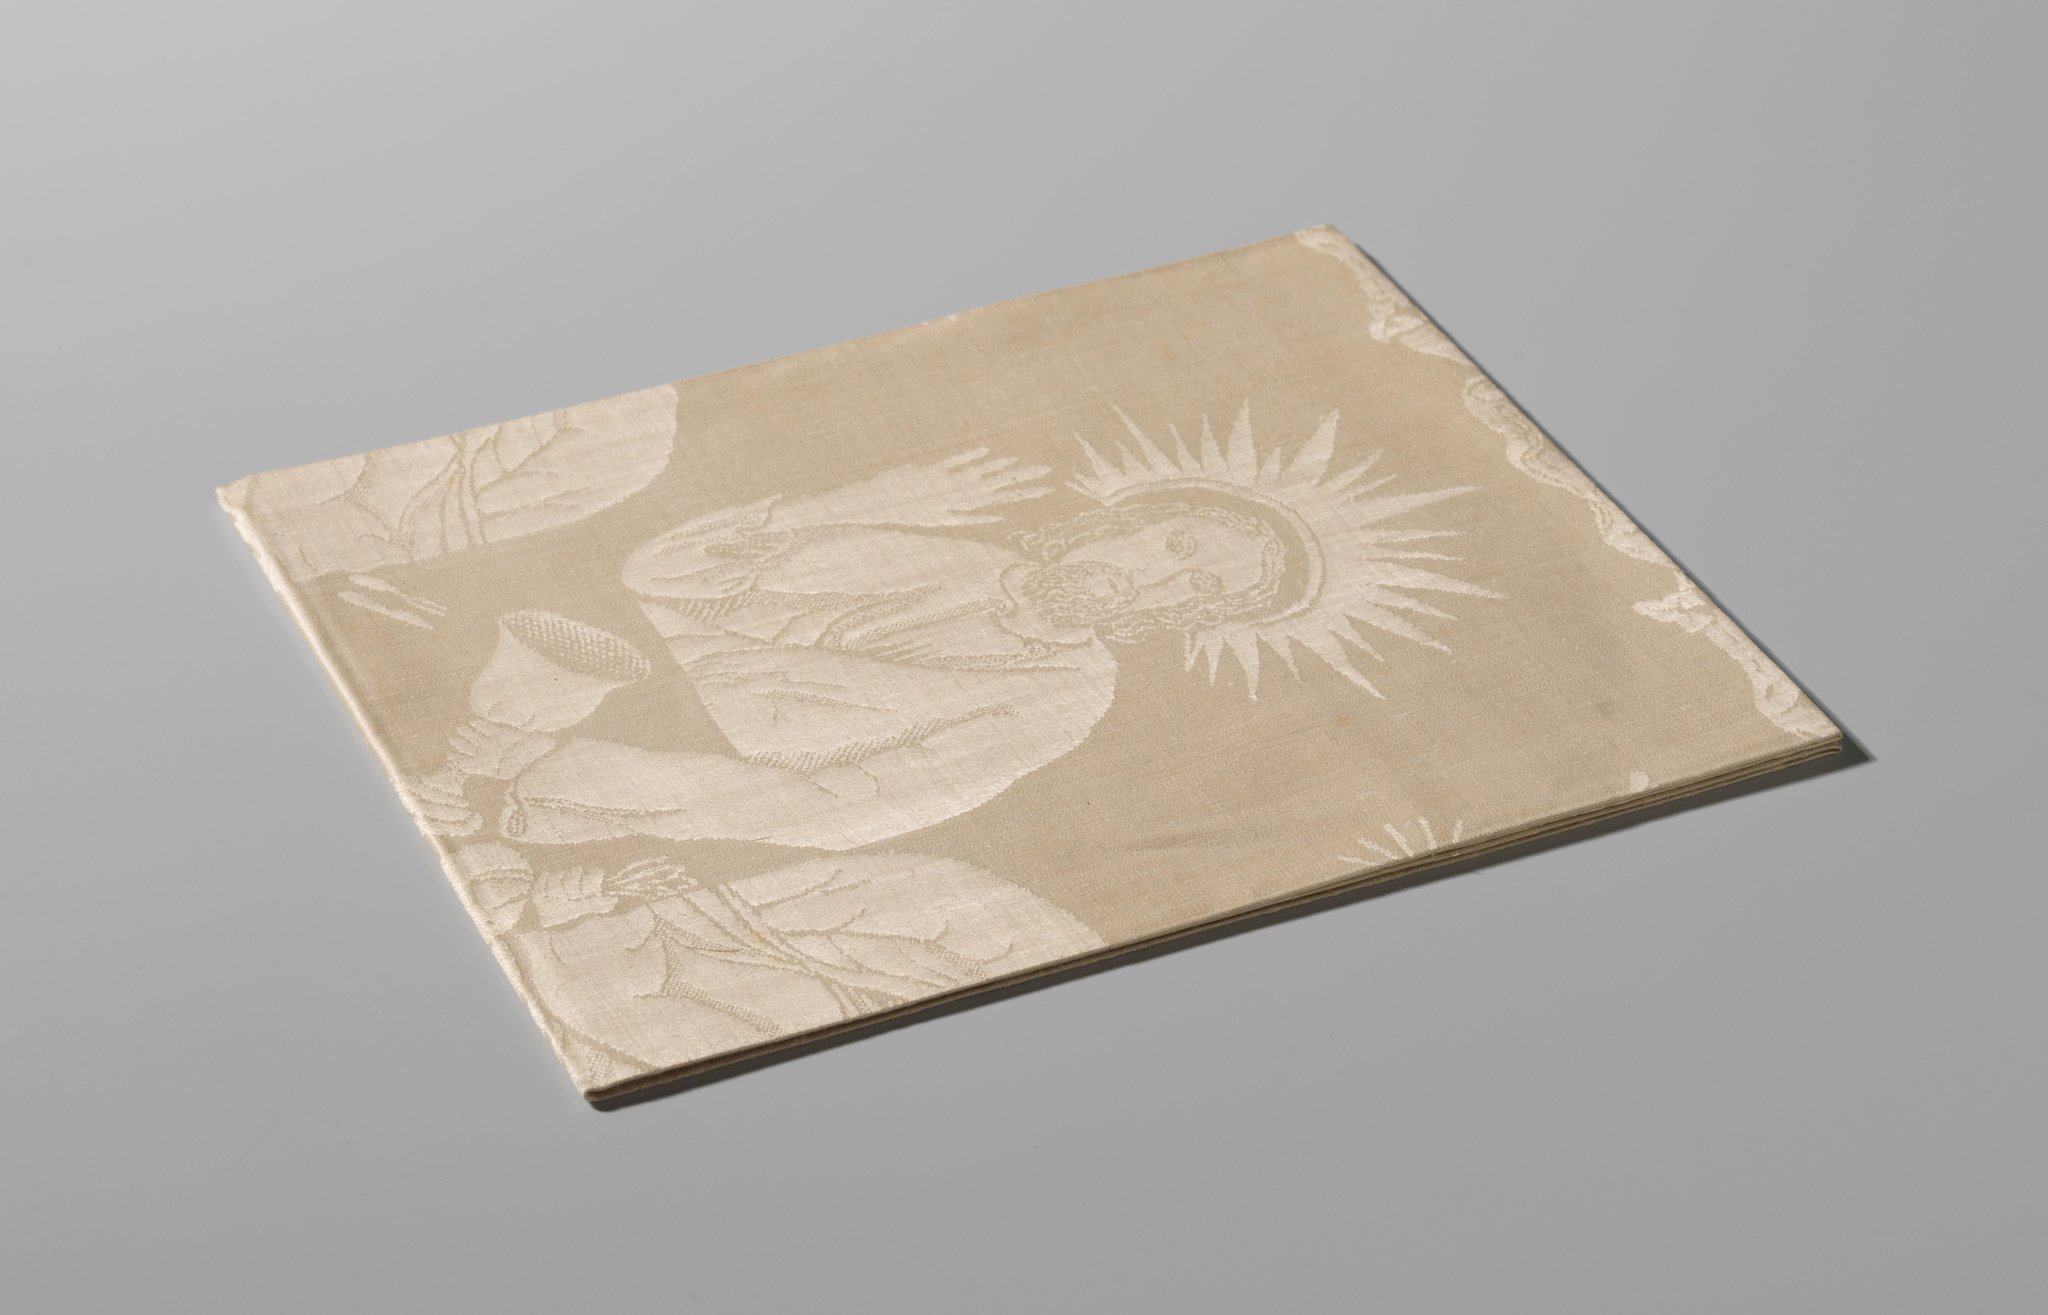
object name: napkin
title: Servet van wit linnendamast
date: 1859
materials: linen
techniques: damask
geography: borne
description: Wit linnen damasten servet met een voorstelling van het Laatste Avondmaal.